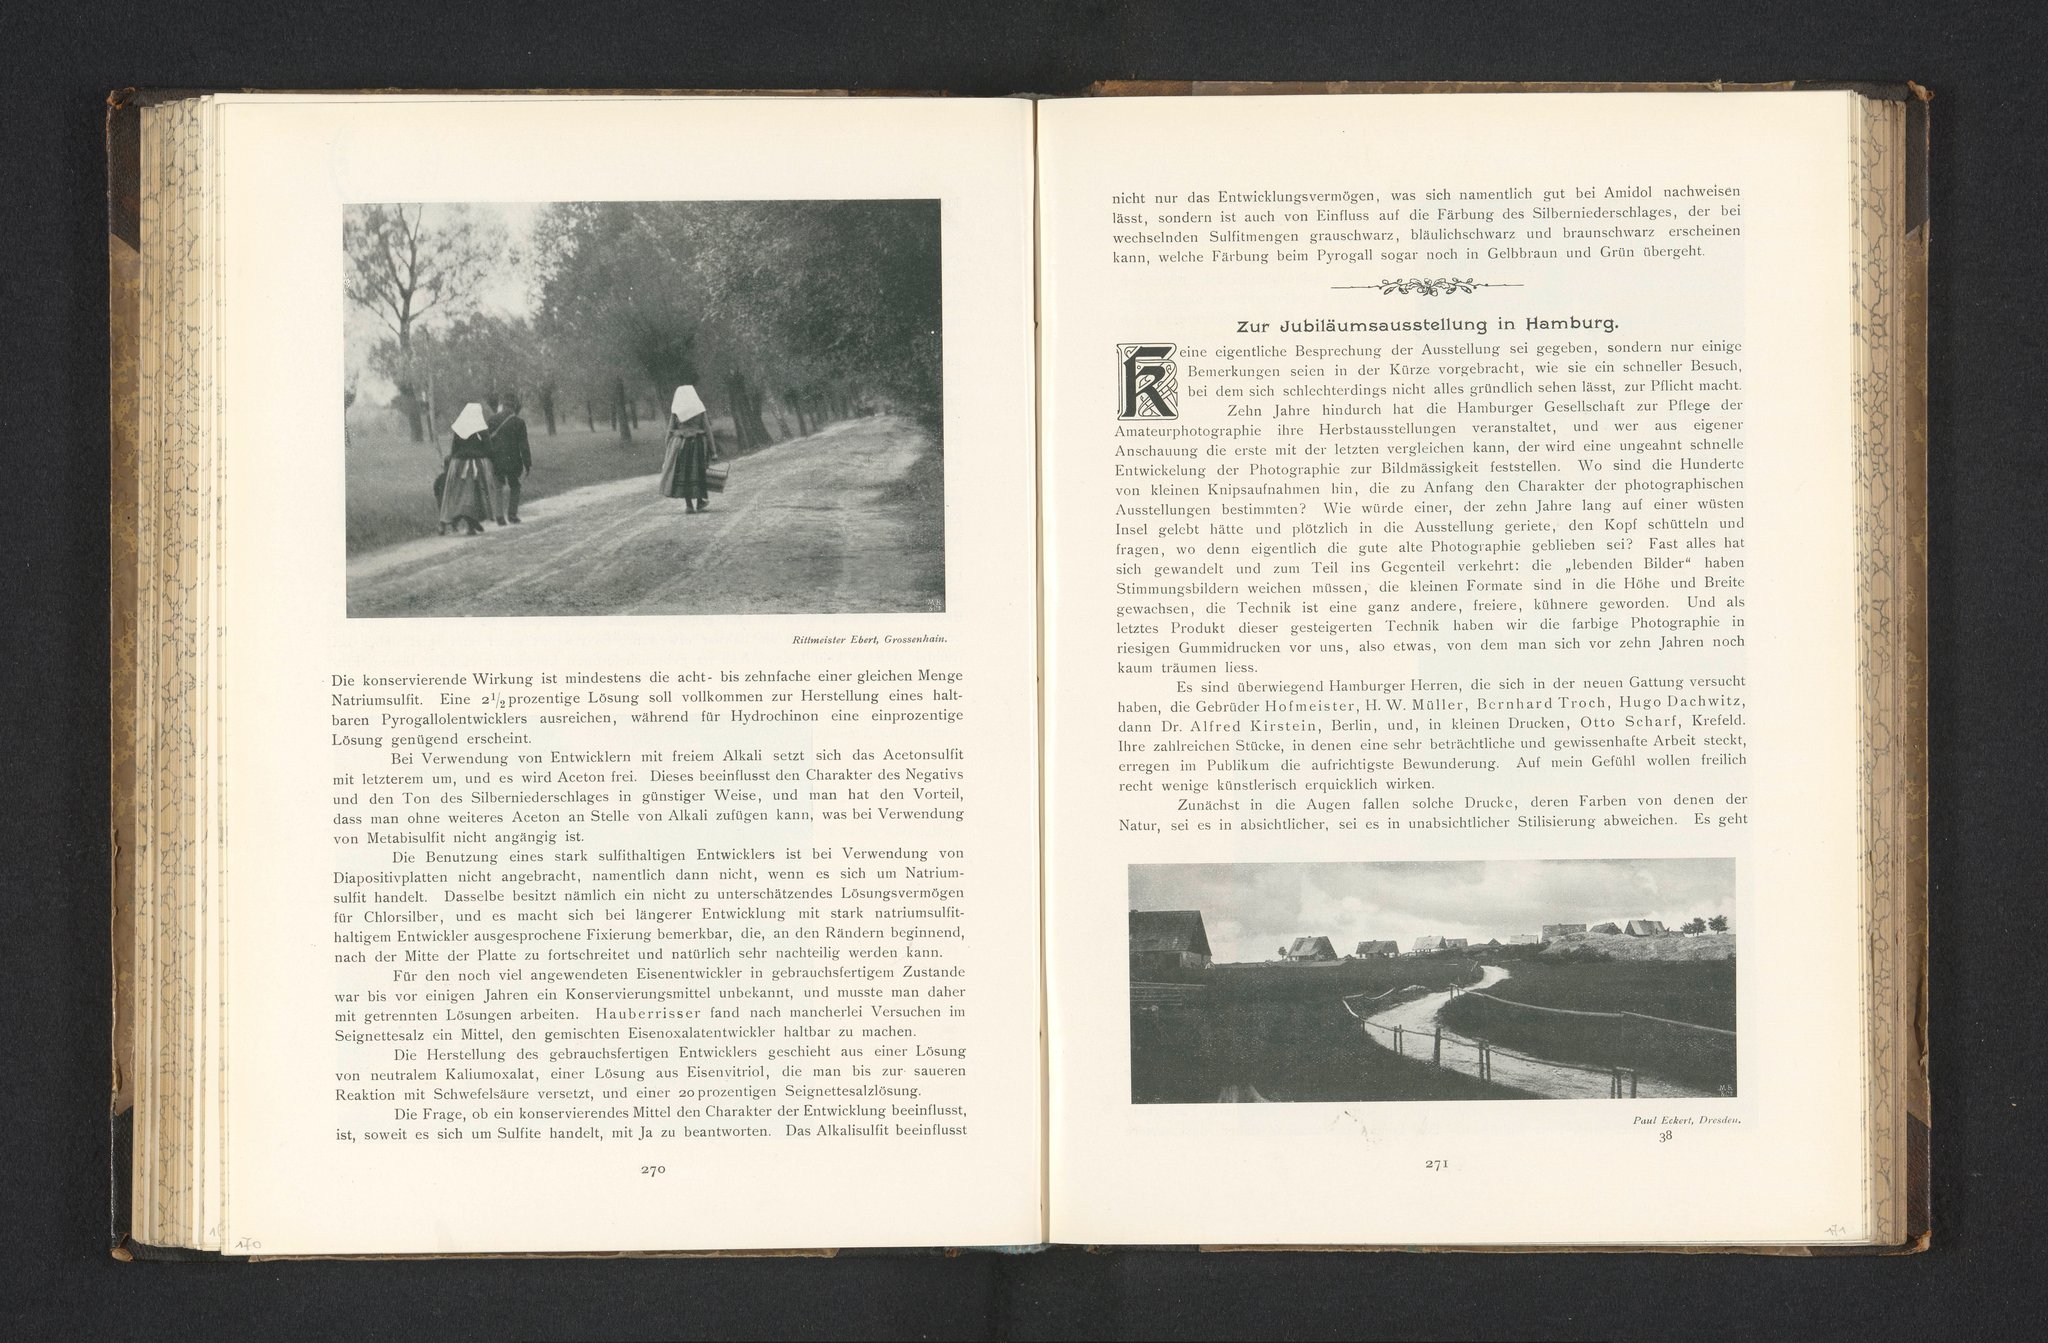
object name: photomechanical print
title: Gezicht op een landweg, met op de achtergrond een dorp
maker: paul eckert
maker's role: fotograaf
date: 1898-1903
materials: paper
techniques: autotype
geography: berlin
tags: village, road, path